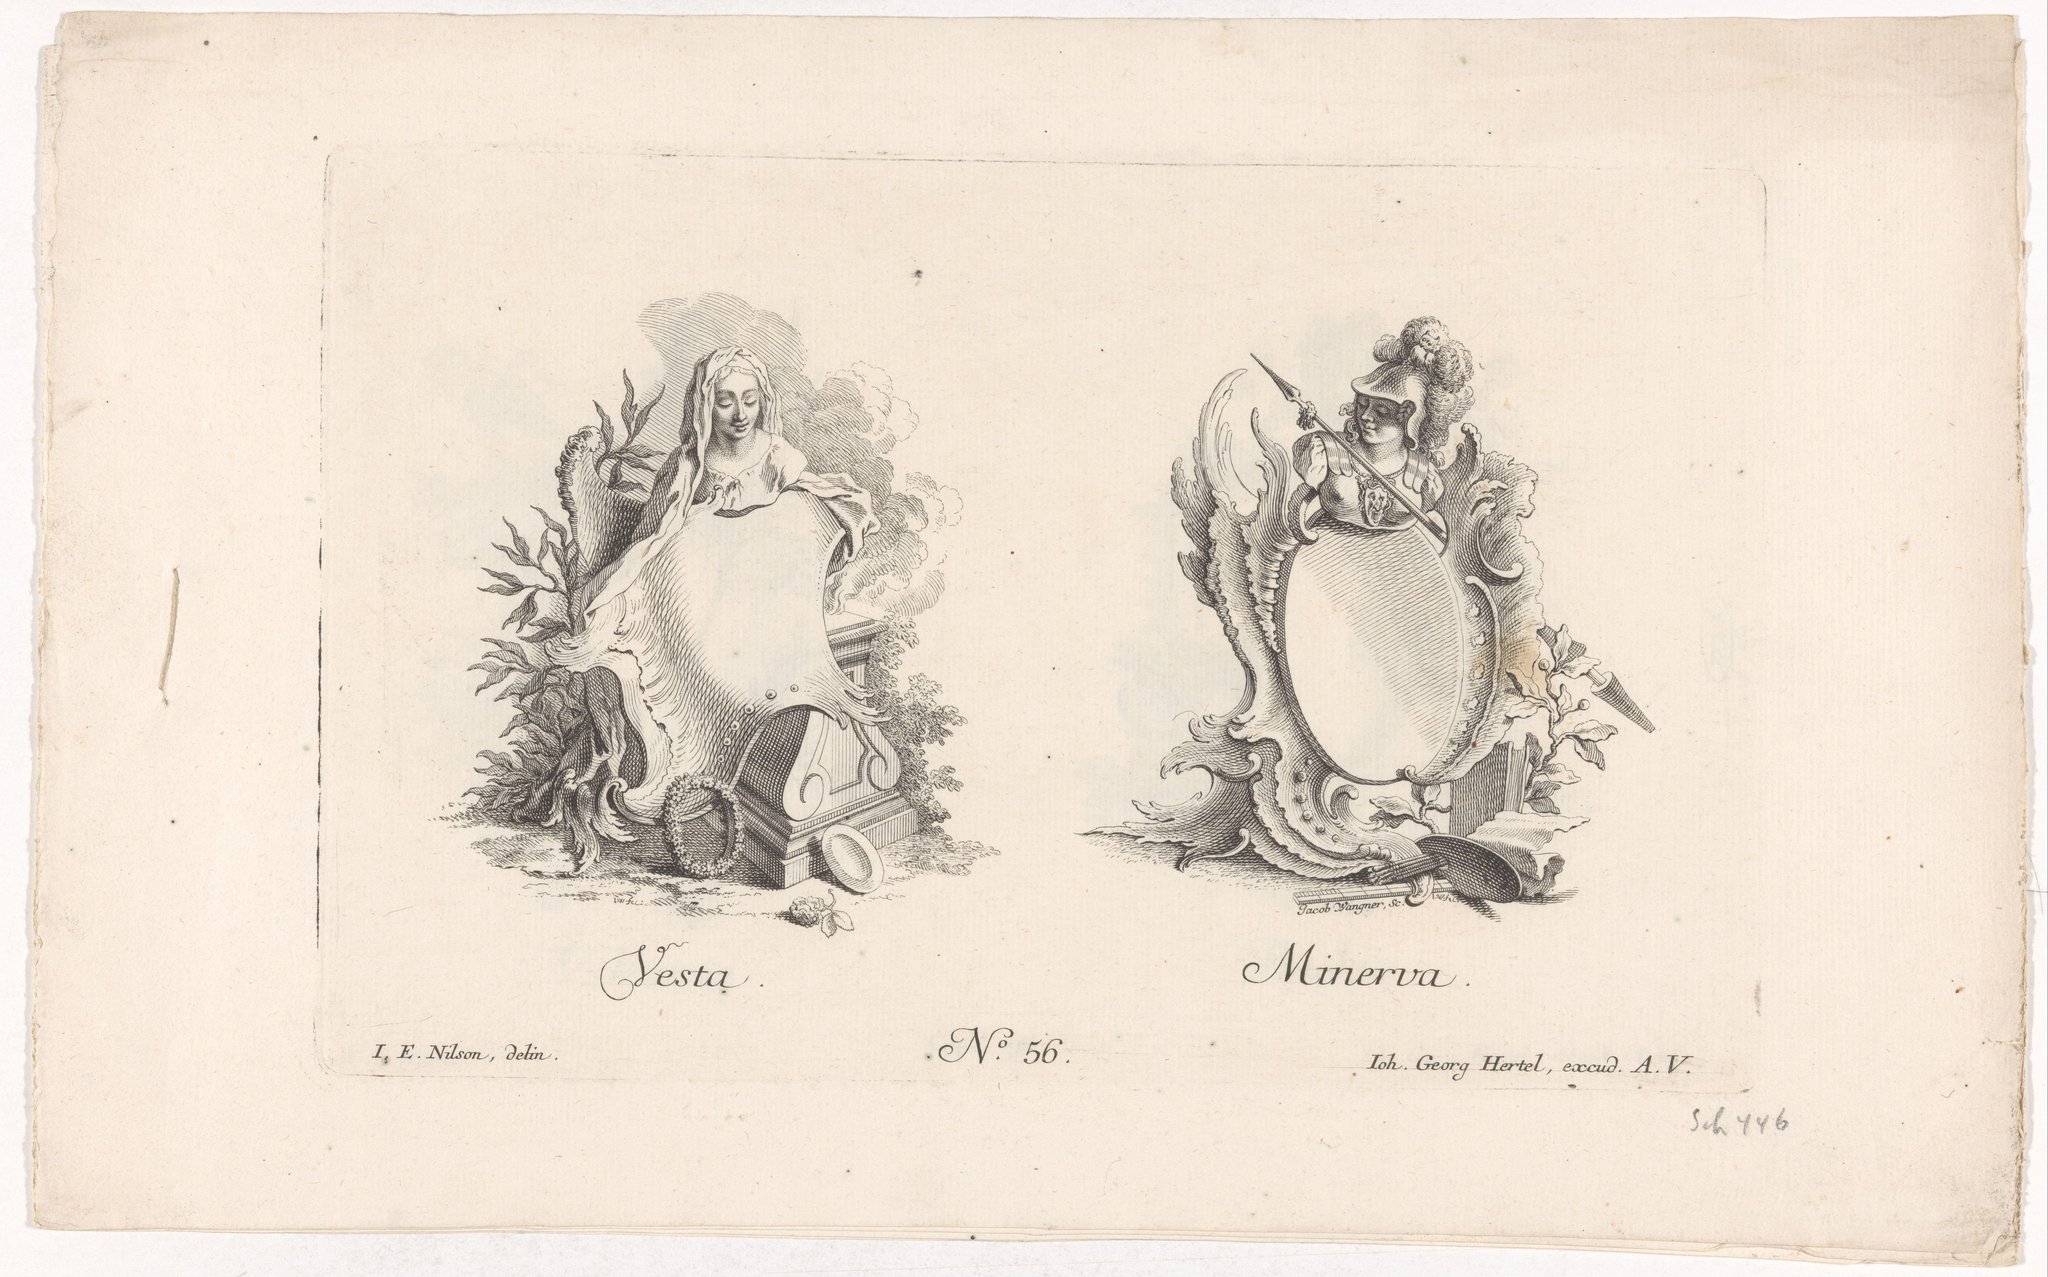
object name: print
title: Dagdelen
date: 1713-1766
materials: paper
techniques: engraving, etching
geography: augsburg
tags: reading, morning, morning star (venus), sunrise, fowl (cock, hen, chicken, etc.)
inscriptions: collector's mark: Lugt 2228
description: Op een rocaille ornament zit een man te lezen. Links naast hem staan boeken. Boven hem verschijnt de opkomende zon en de ochtendster. Links boven zit een haan. In de ondermarge tweemaal een vierregelige Duitse en Latijnse tekst. Uitgeversnummer 82.